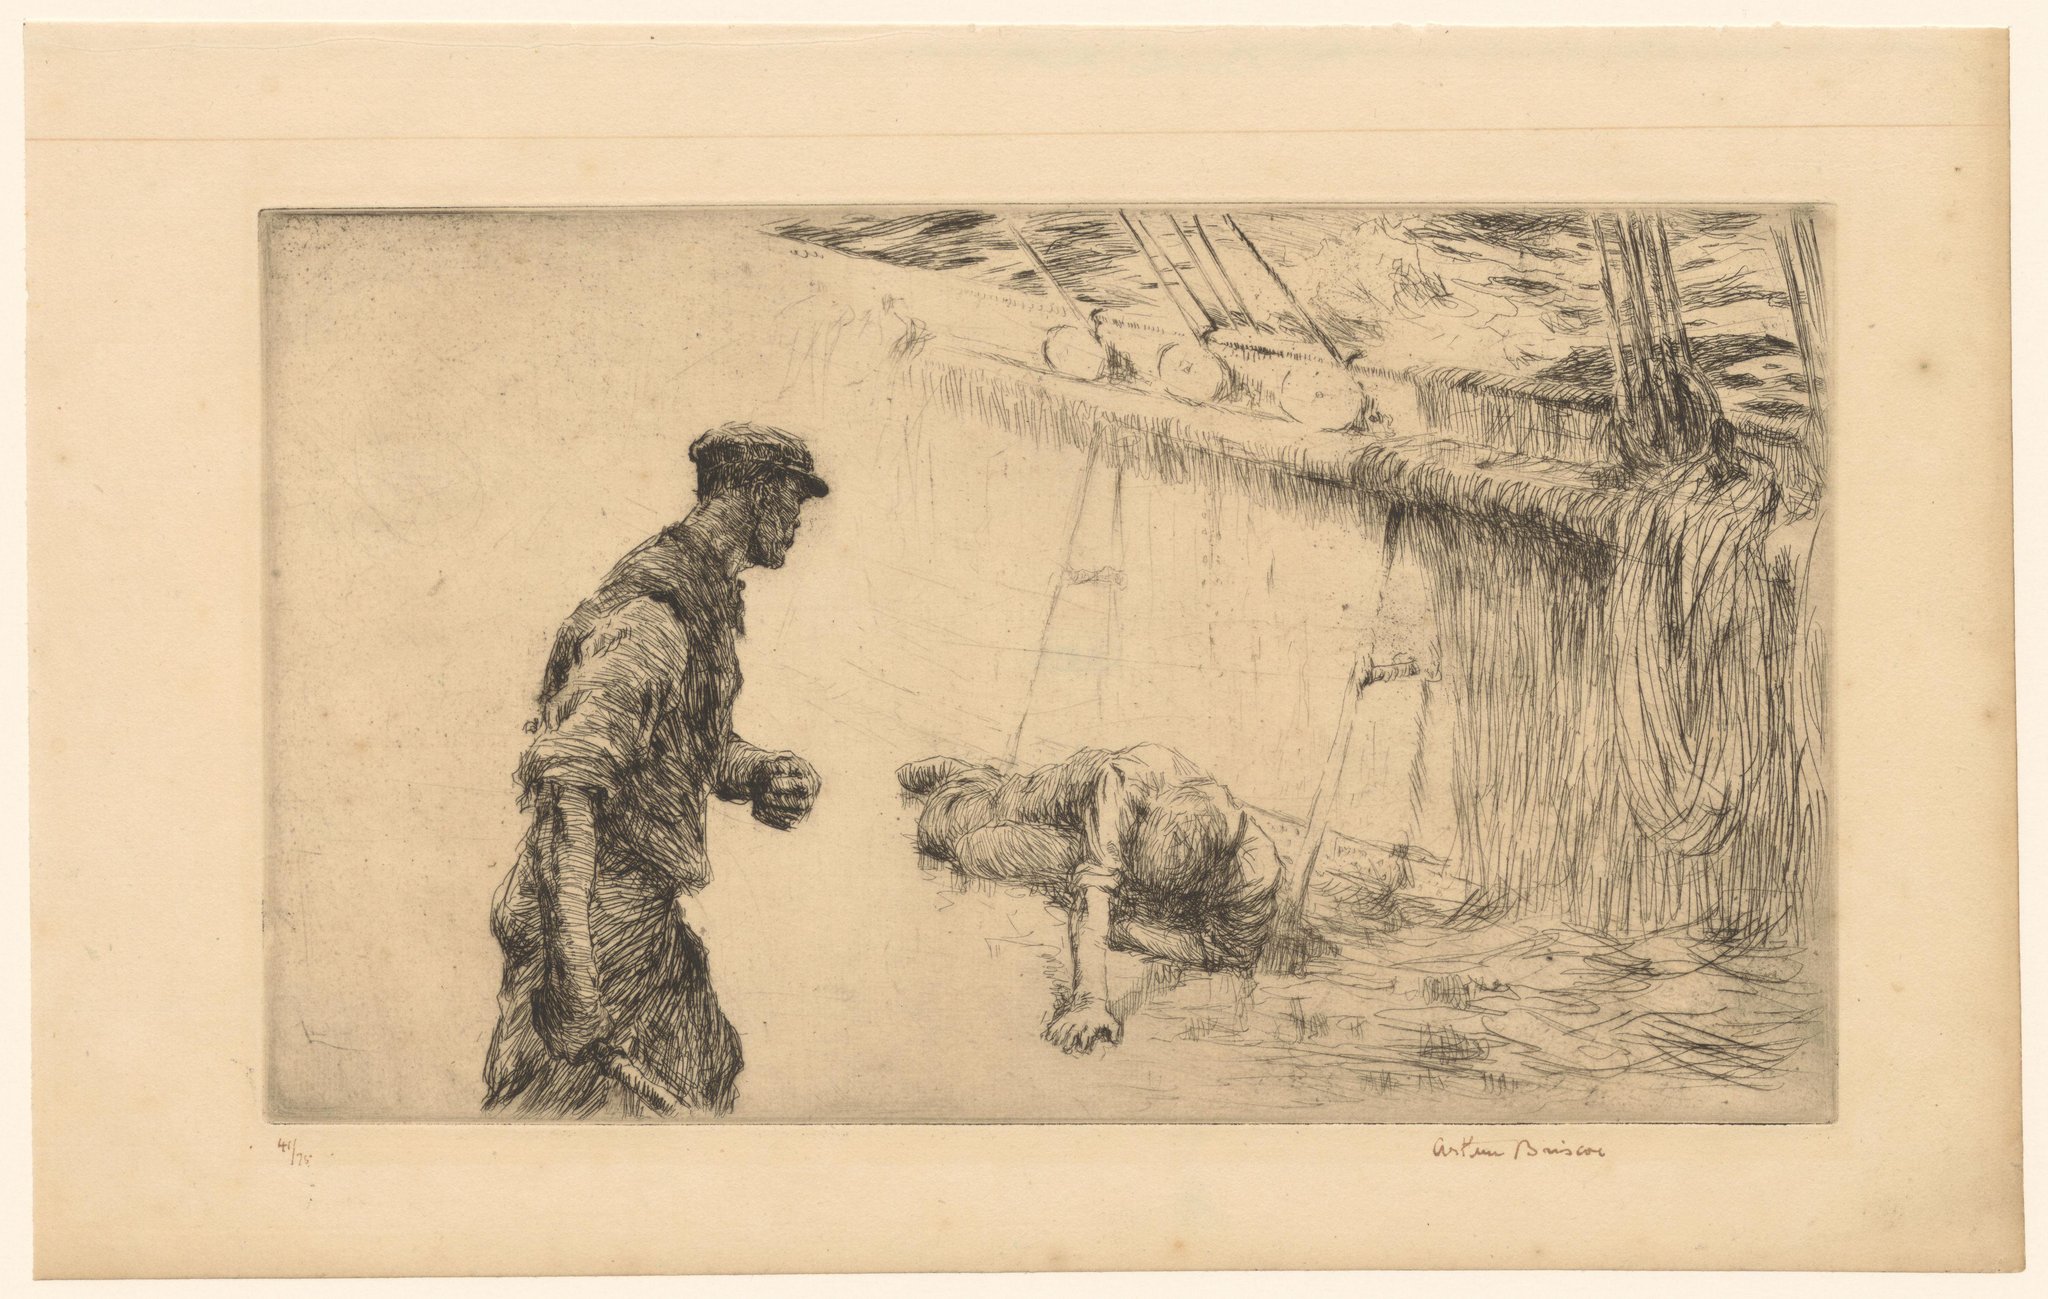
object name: print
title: Matroos neergeslagen door de officier van het schip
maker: arthur john trevor briscoe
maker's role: print maker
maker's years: 1873-1943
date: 1926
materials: paper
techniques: drypoint, etching, intaglio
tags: sailor, officer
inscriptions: collector's mark: Lugt 2228